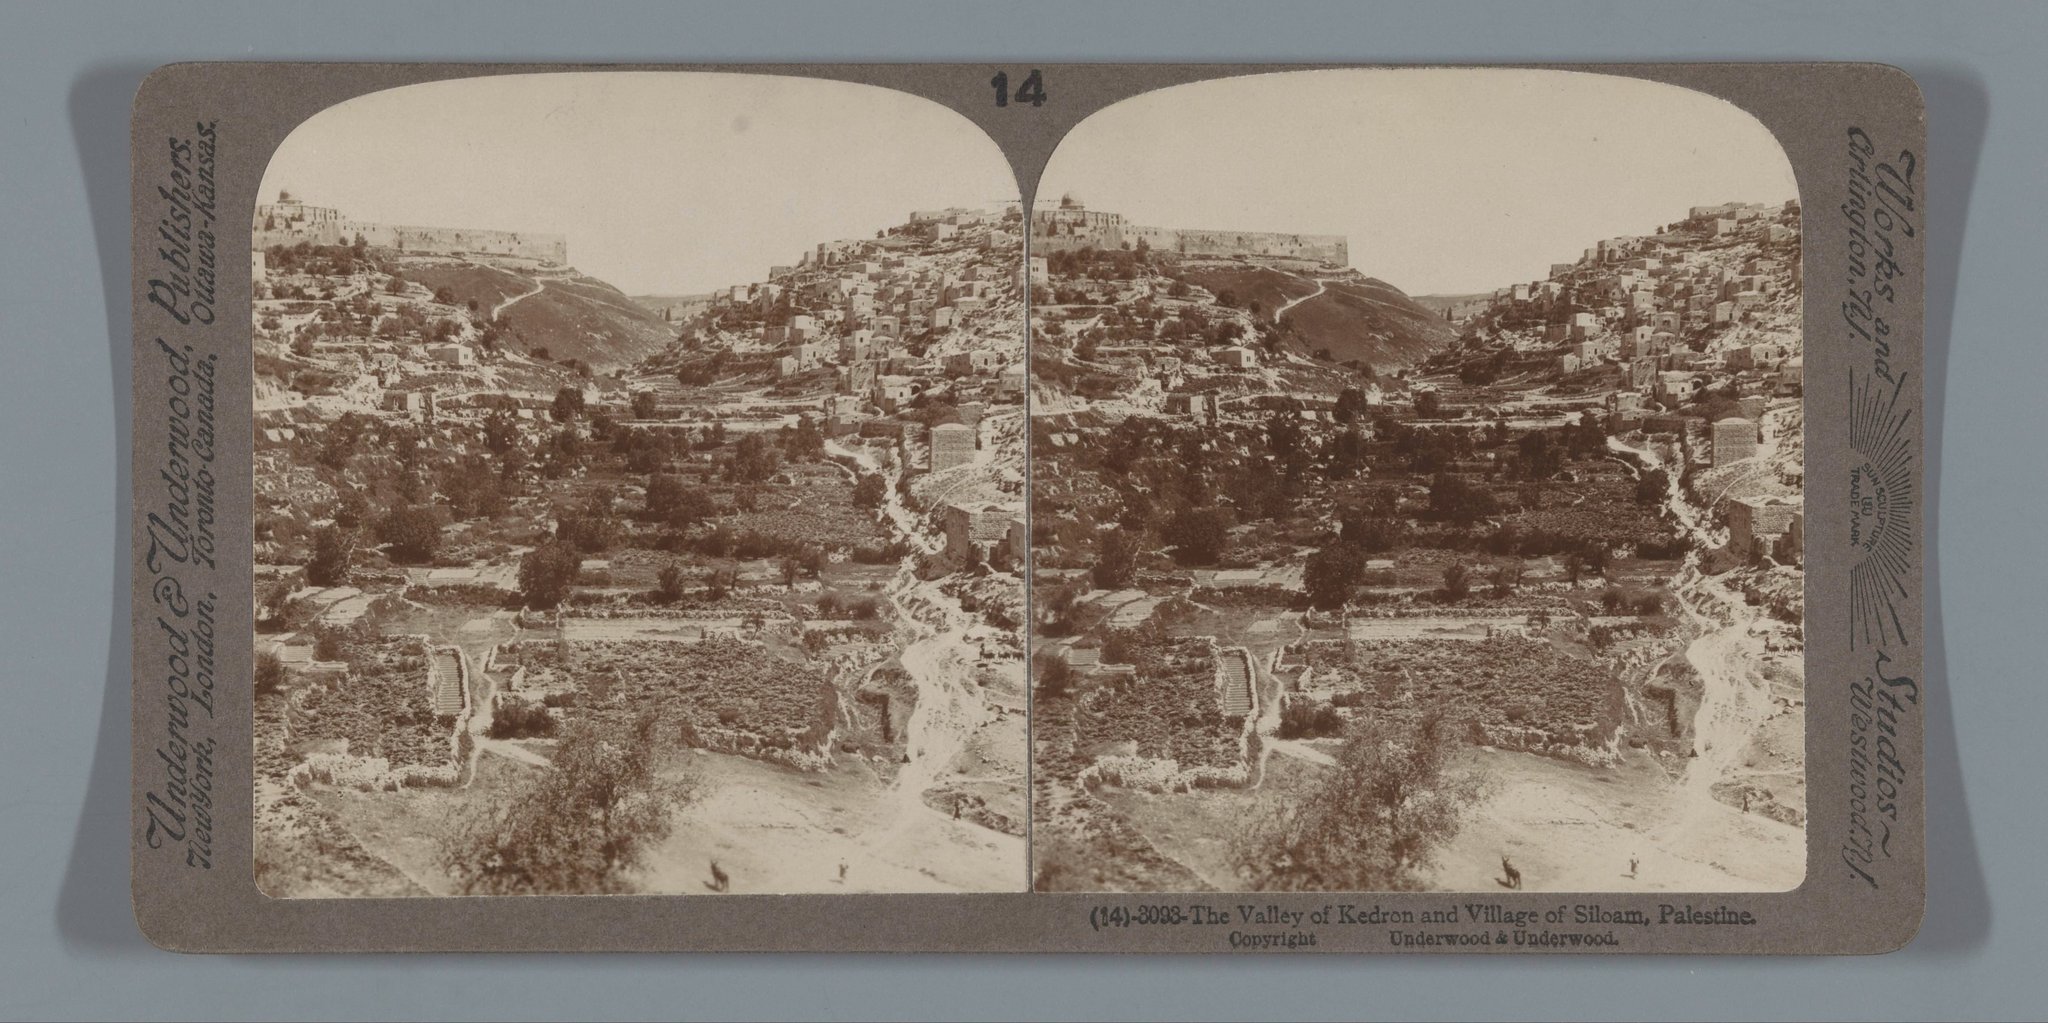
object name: stereograph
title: Gezicht op het Kidrondal en het dorp Siloam, nabij Jeruzalem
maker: Anonymous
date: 1900-1906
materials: paper, cardboard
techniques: gelatin silver print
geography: kidron valley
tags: dale, valley, village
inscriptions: copyright notice: ‘Copyright Underwood & Underwood.’, number: ‘14’, number: ‘3093’, inscription, number: ‘(14)-3098-’, inscription: ‘We are standing on a spur of the Hill of Evil Counsel (...) From Notes of Travel No. 36, copyright 1906 by Underwood & Underwood.’, inscription: ‘Works and Studios ~/ Arlington, N.J. Westwood, N.J.’